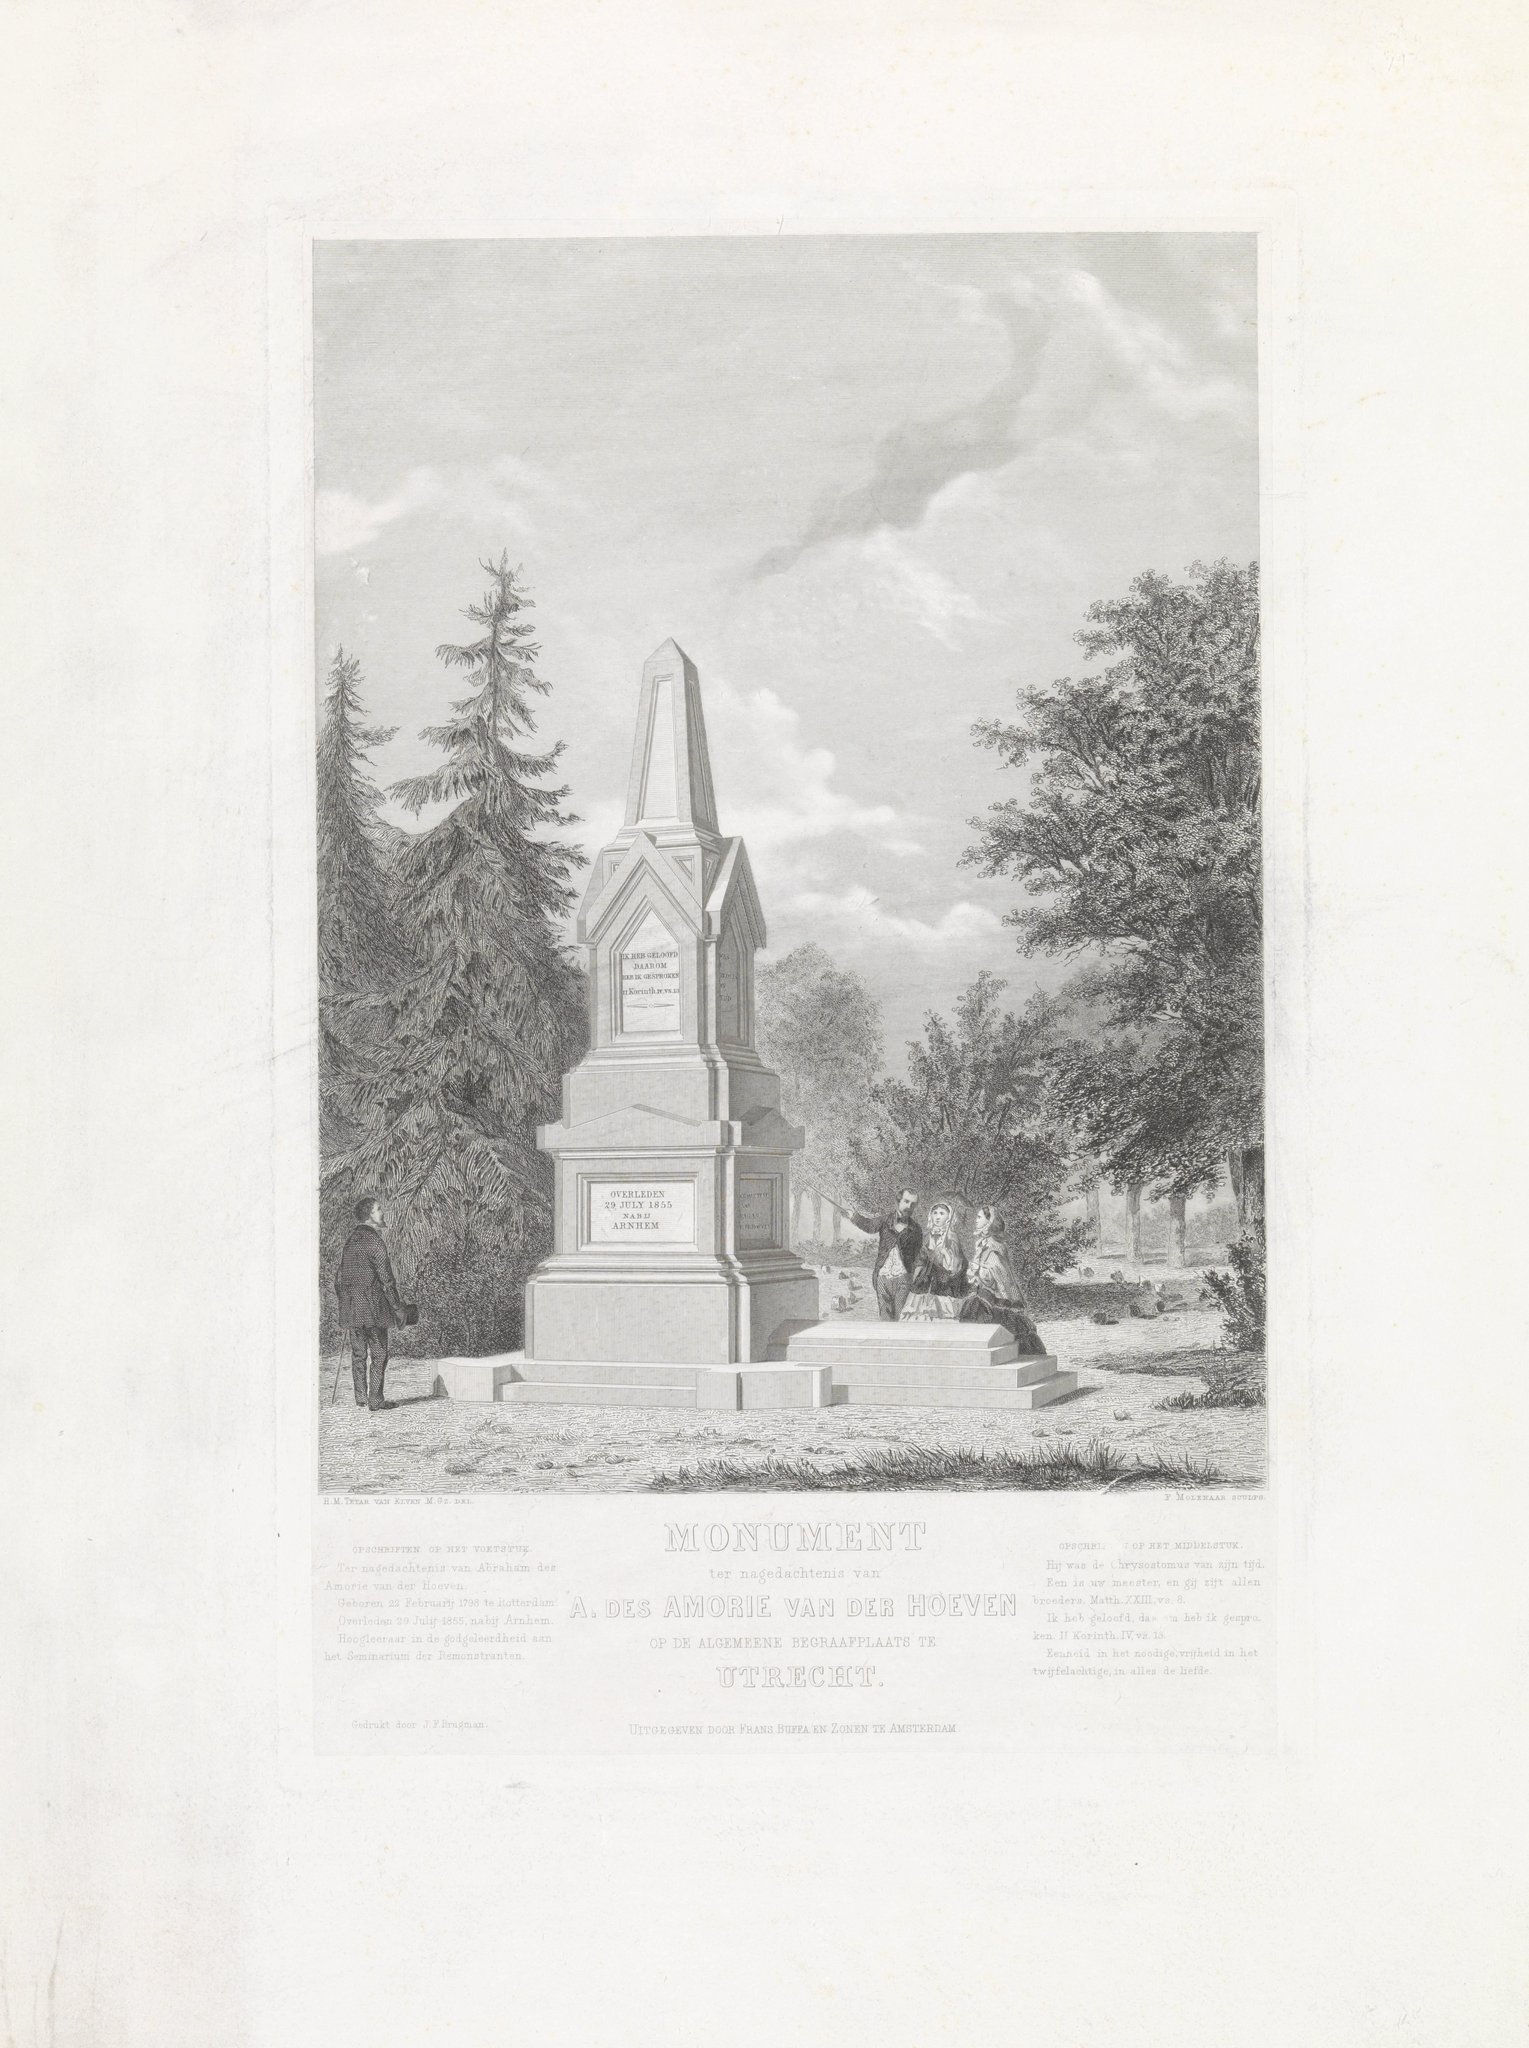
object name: print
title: Grafmonument voor Abraham des Amorie van der Hoeven (I)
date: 1855-1886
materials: paper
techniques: engraving, etching, letterpress printing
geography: amsterdam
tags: rotterdam, arnhem, trees, needle, obelisk (marking grave)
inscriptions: collector's mark: Lugt 2233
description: Grafmonument voor remonstrants predikant en theoloog Abraham des Amorie van der Hoeven (I) op de begraafplaats Soestbergen te Utrecht. Daarbij twee mannen en twee vrouwen. Onderaan in de marge de opschriften op het monument.